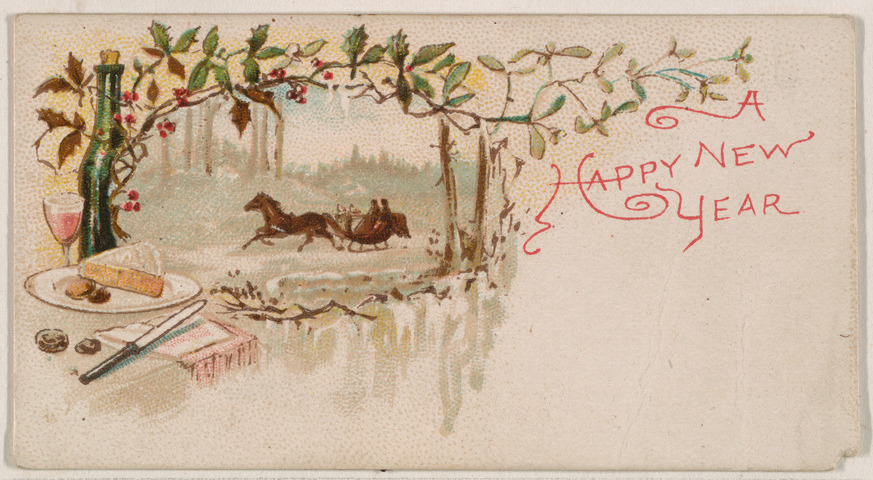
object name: print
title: A Happy New Year, from the New Years 1890 series (N227) issued by Kinney Bros.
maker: kinney brothers tobacco company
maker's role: publisher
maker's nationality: american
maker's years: 1869-2011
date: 1889-1890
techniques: color lithograph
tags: food,human figures,horses,carriages